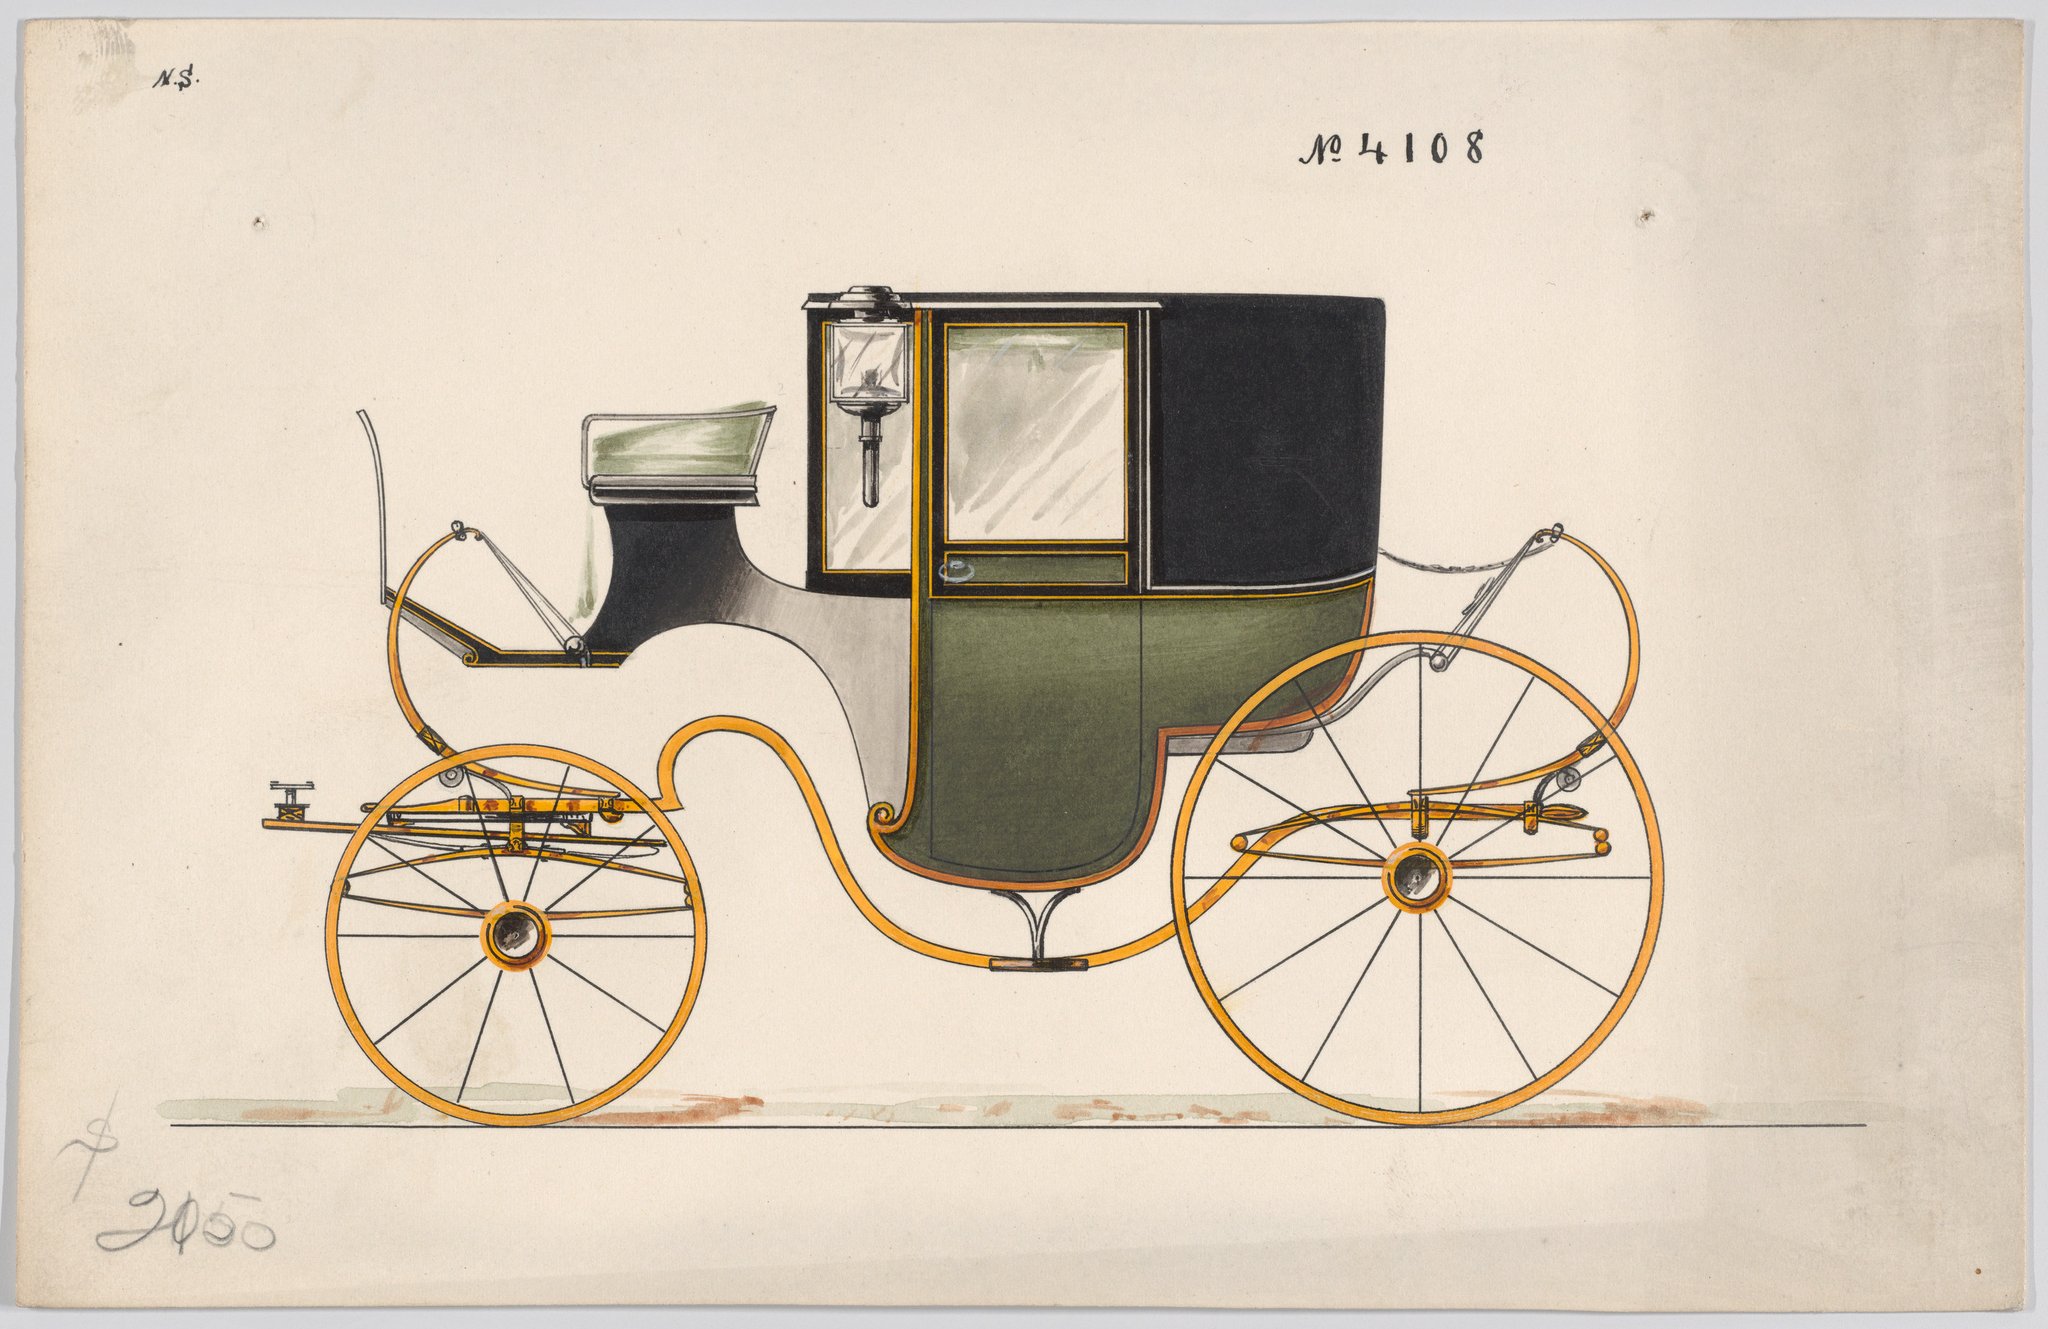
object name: drawing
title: Design for Coupé, no. 4108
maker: brewster & co.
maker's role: manufacturer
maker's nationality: american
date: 1890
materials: gouache, gum arabic, ink, watercolor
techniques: pen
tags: carriages